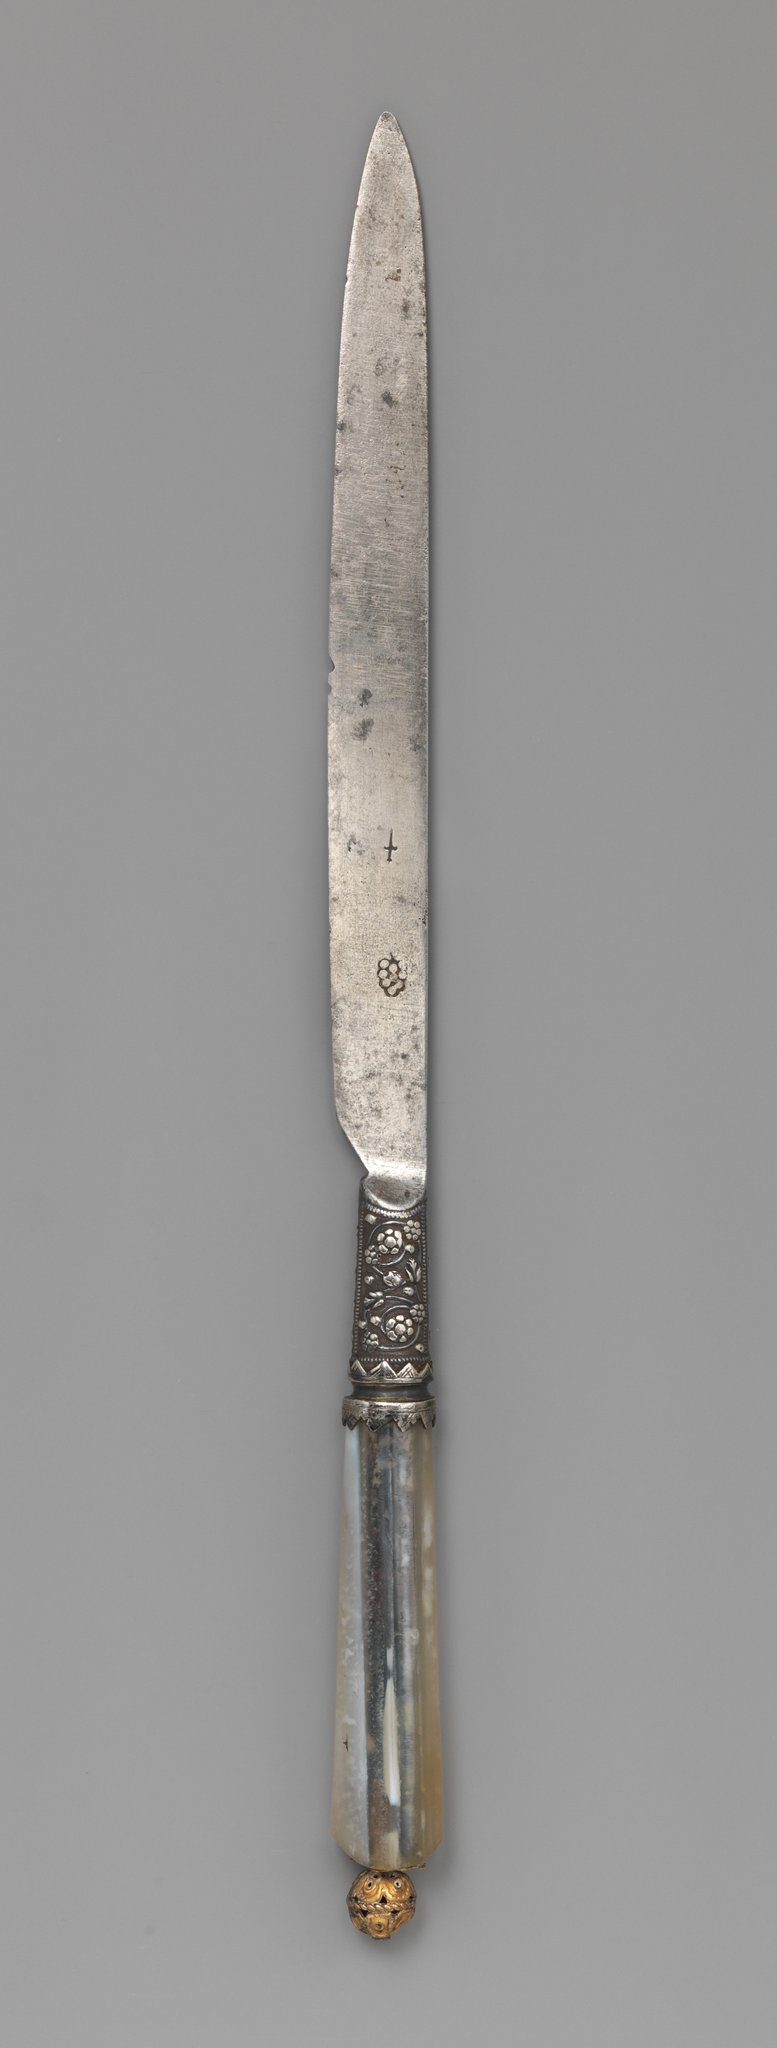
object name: table knife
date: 1601-1625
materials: stone, steel